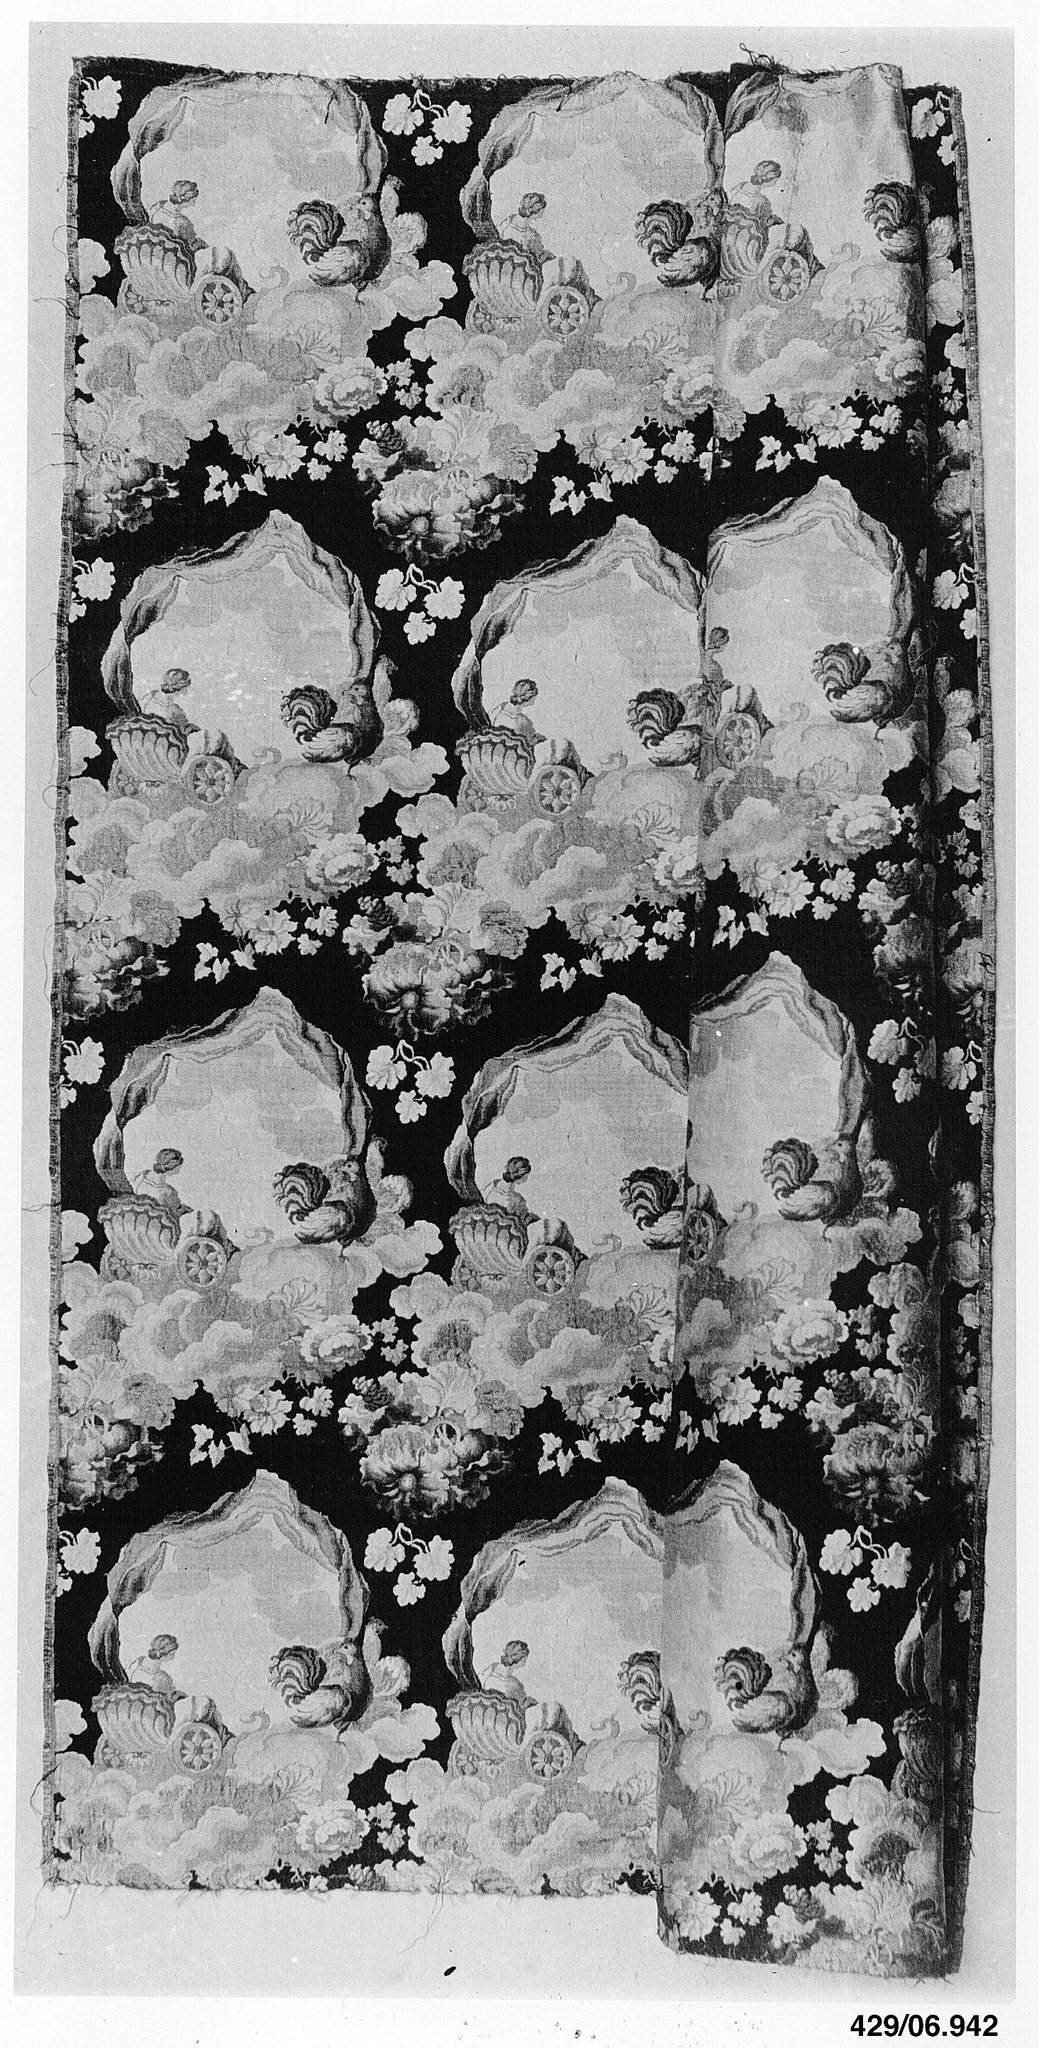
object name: piece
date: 1735-1740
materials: metal thread, silk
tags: chickens,chariots